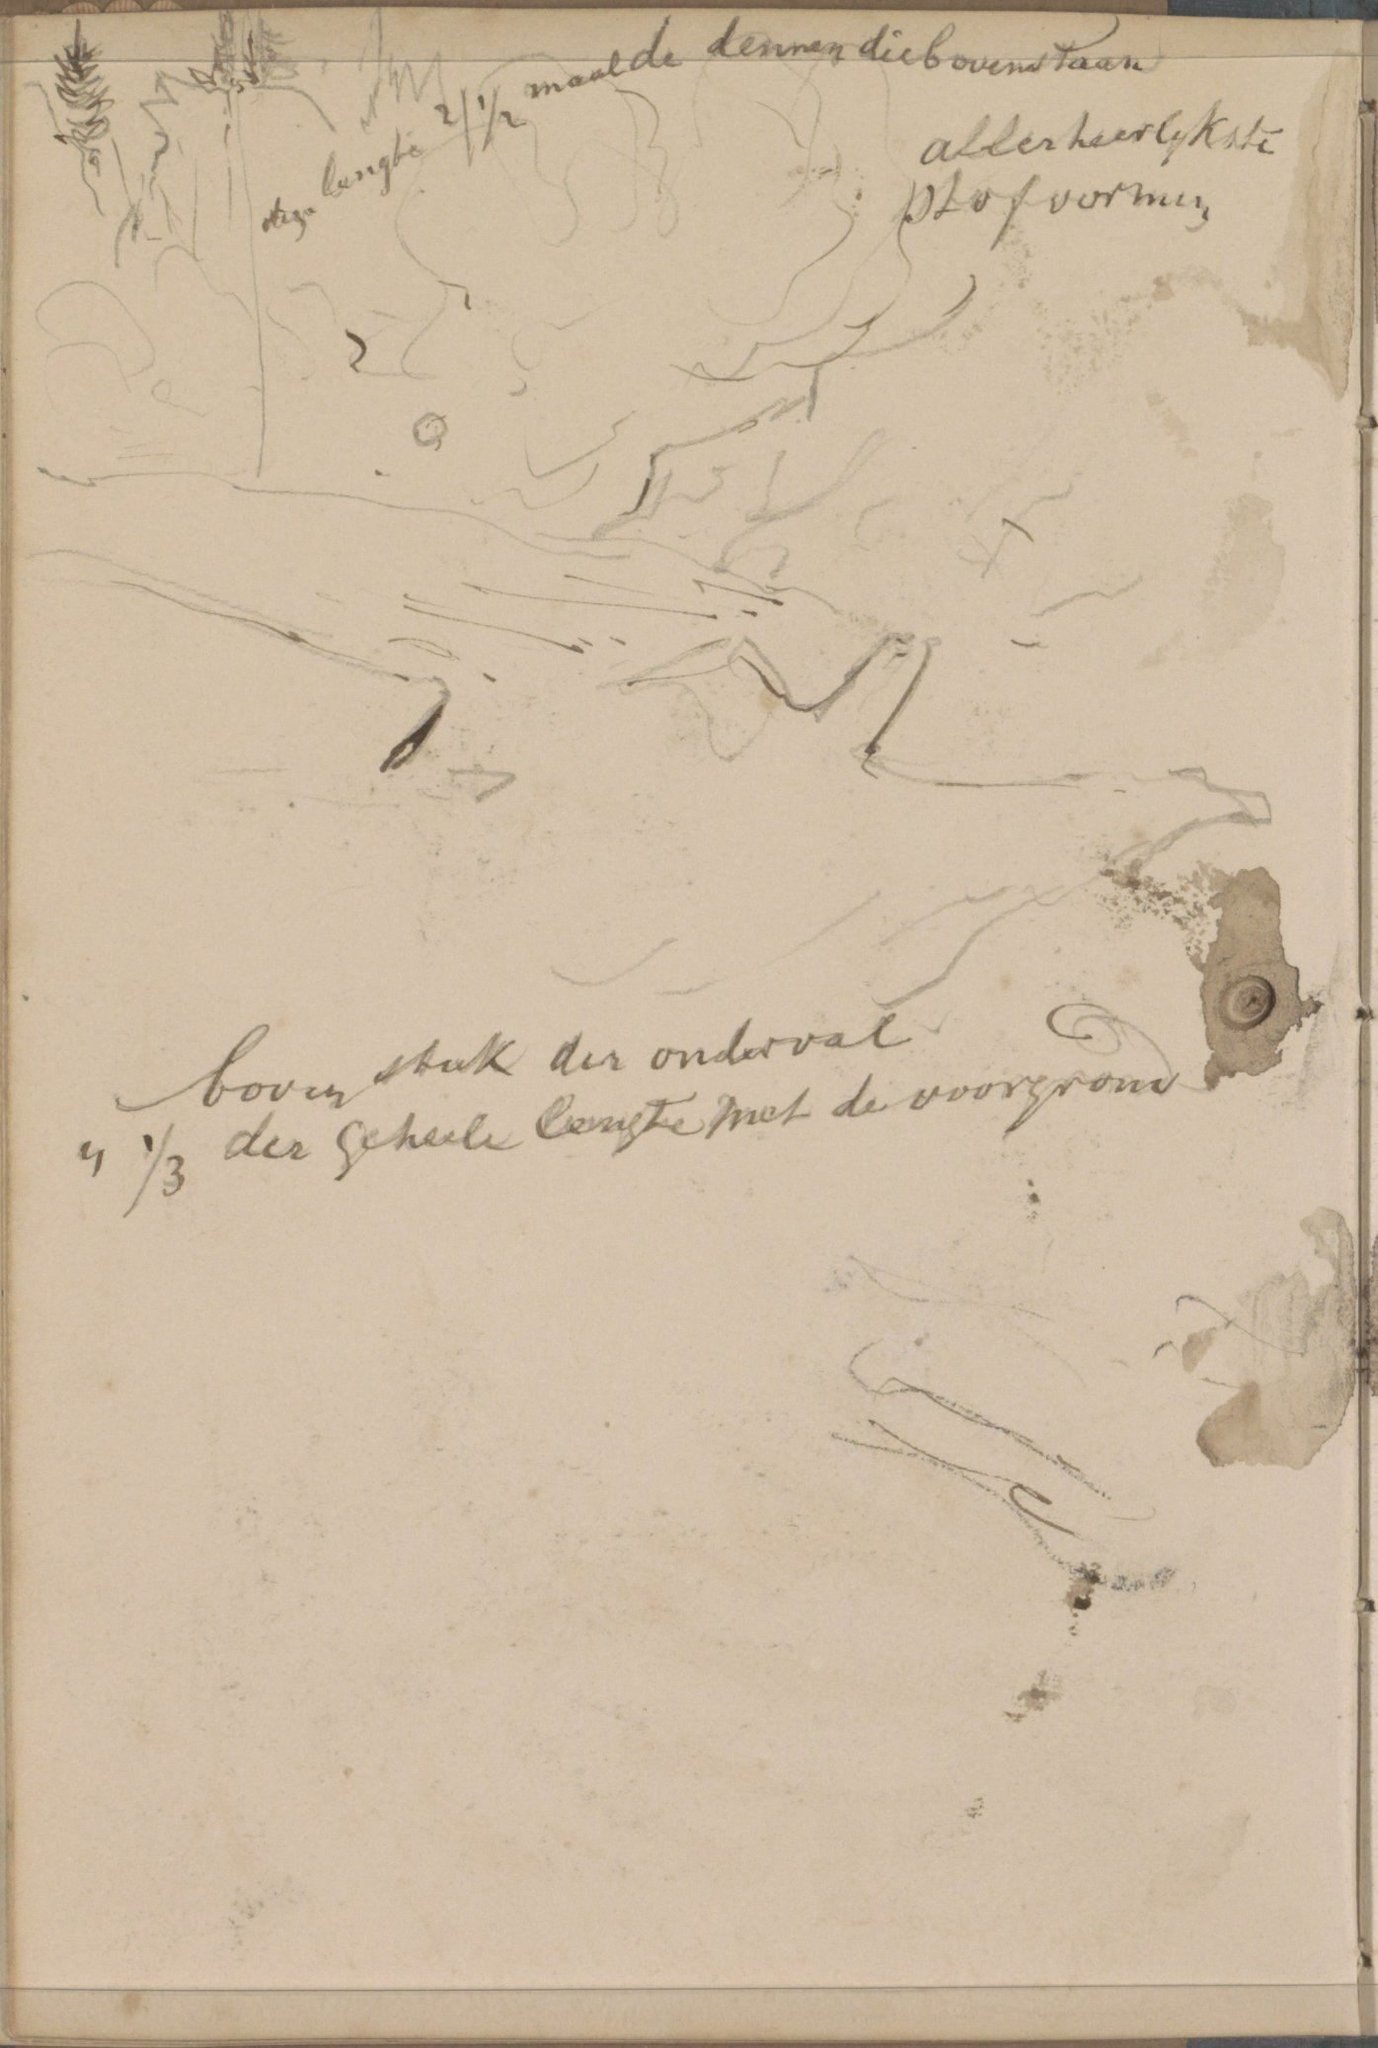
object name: sketchbook leaf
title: Dennenbomen bovenaan een waterval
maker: johannes tavenraat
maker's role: draughtsman, painter, print maker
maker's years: 1809-1881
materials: ink, paper, pencil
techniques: pen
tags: waterfall, trees: pine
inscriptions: annotation: ‘[...]’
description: Blad 14 verso uit een schetsboek met 47 bladen.